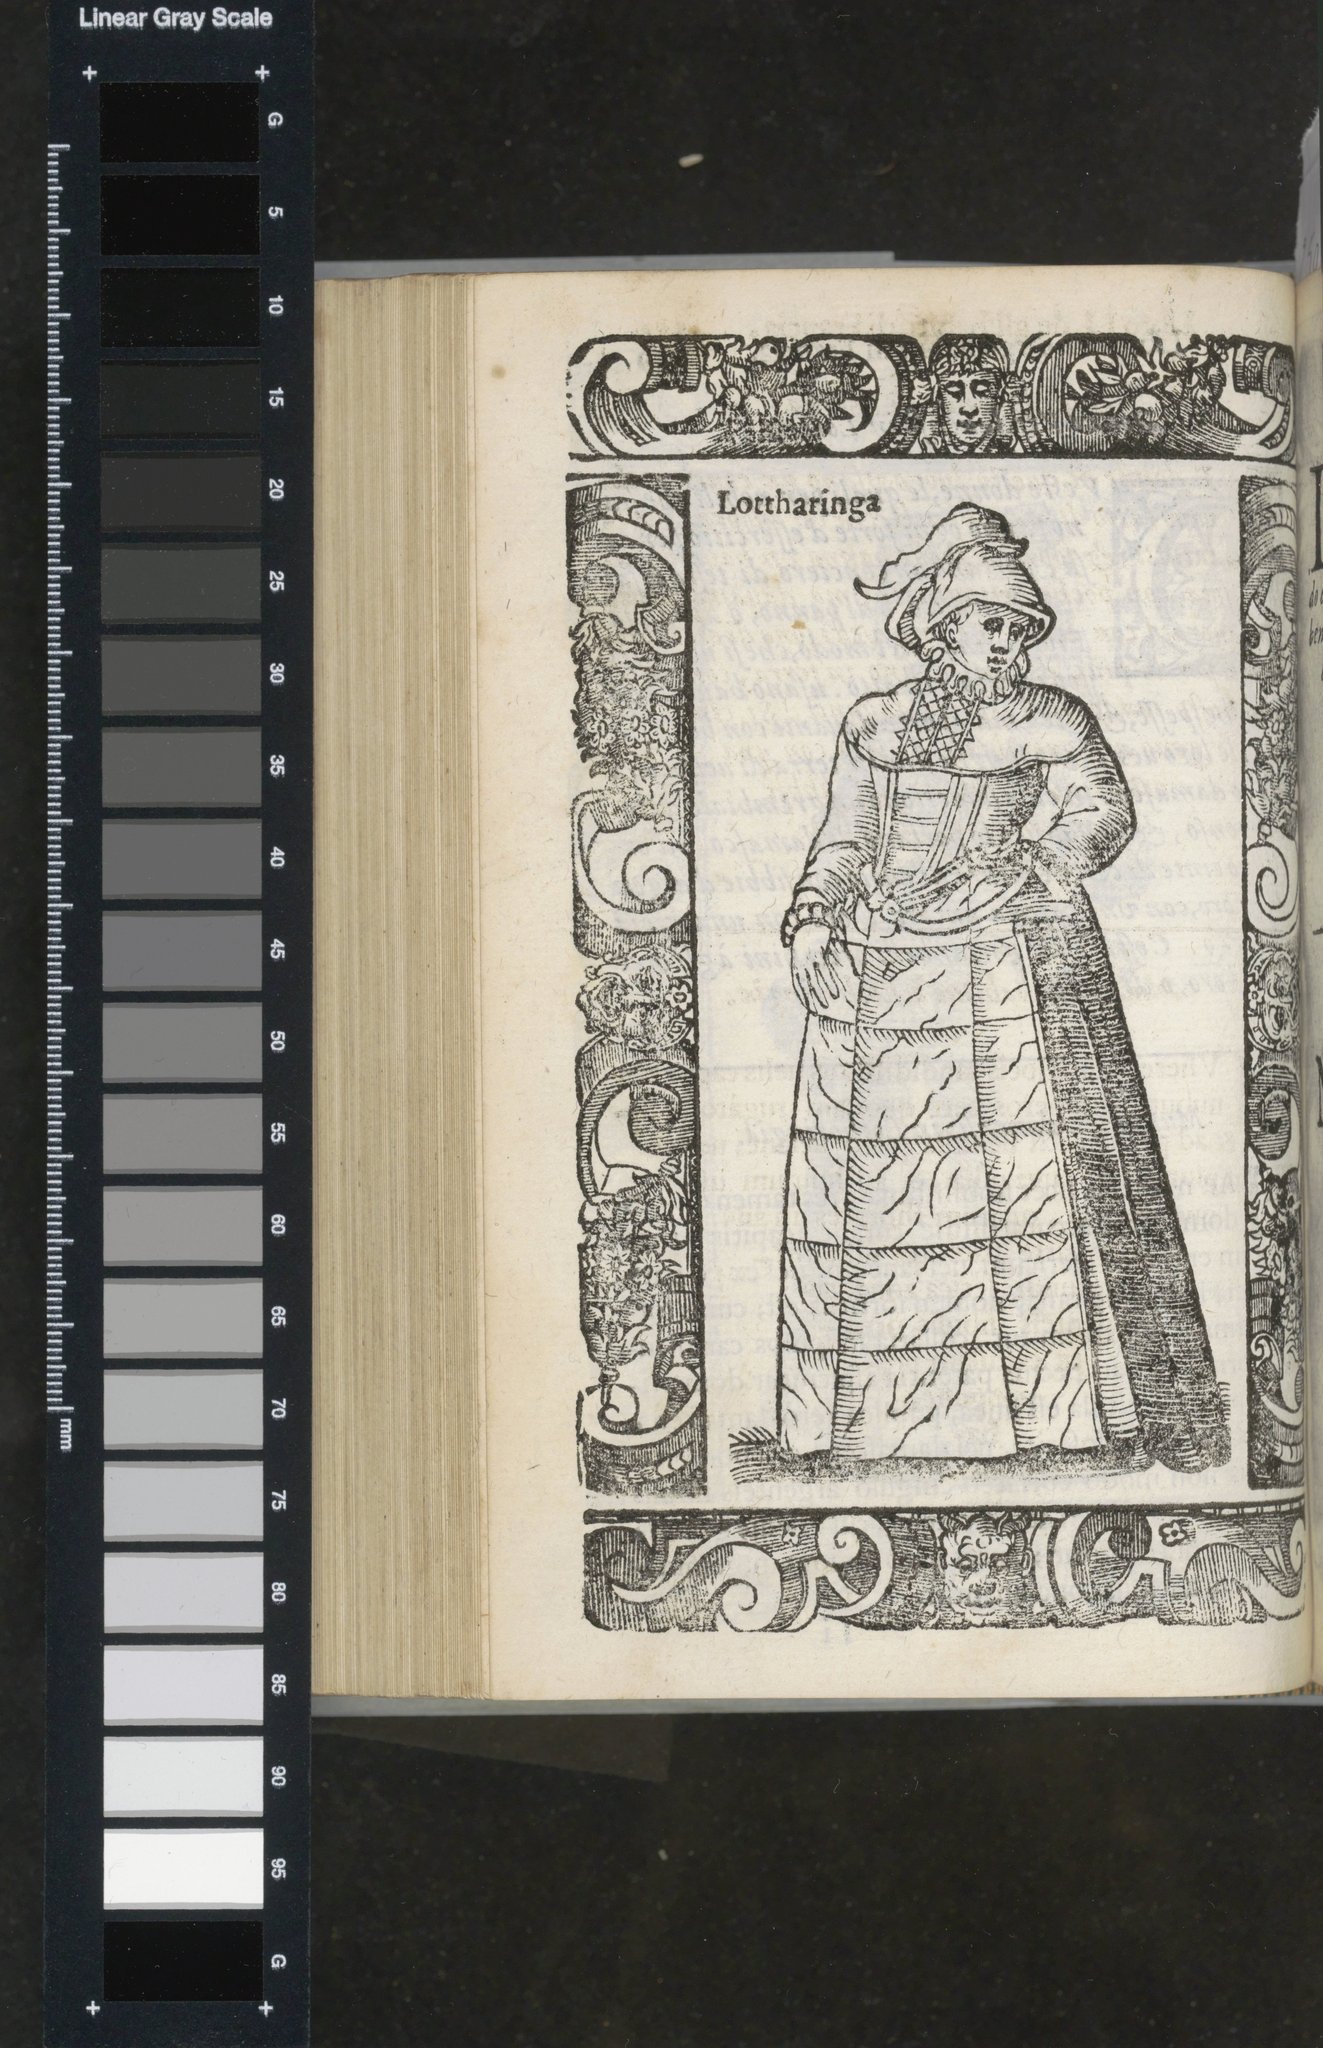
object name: costume print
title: Lottharina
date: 1598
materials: paper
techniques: woodcut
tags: fashion plates